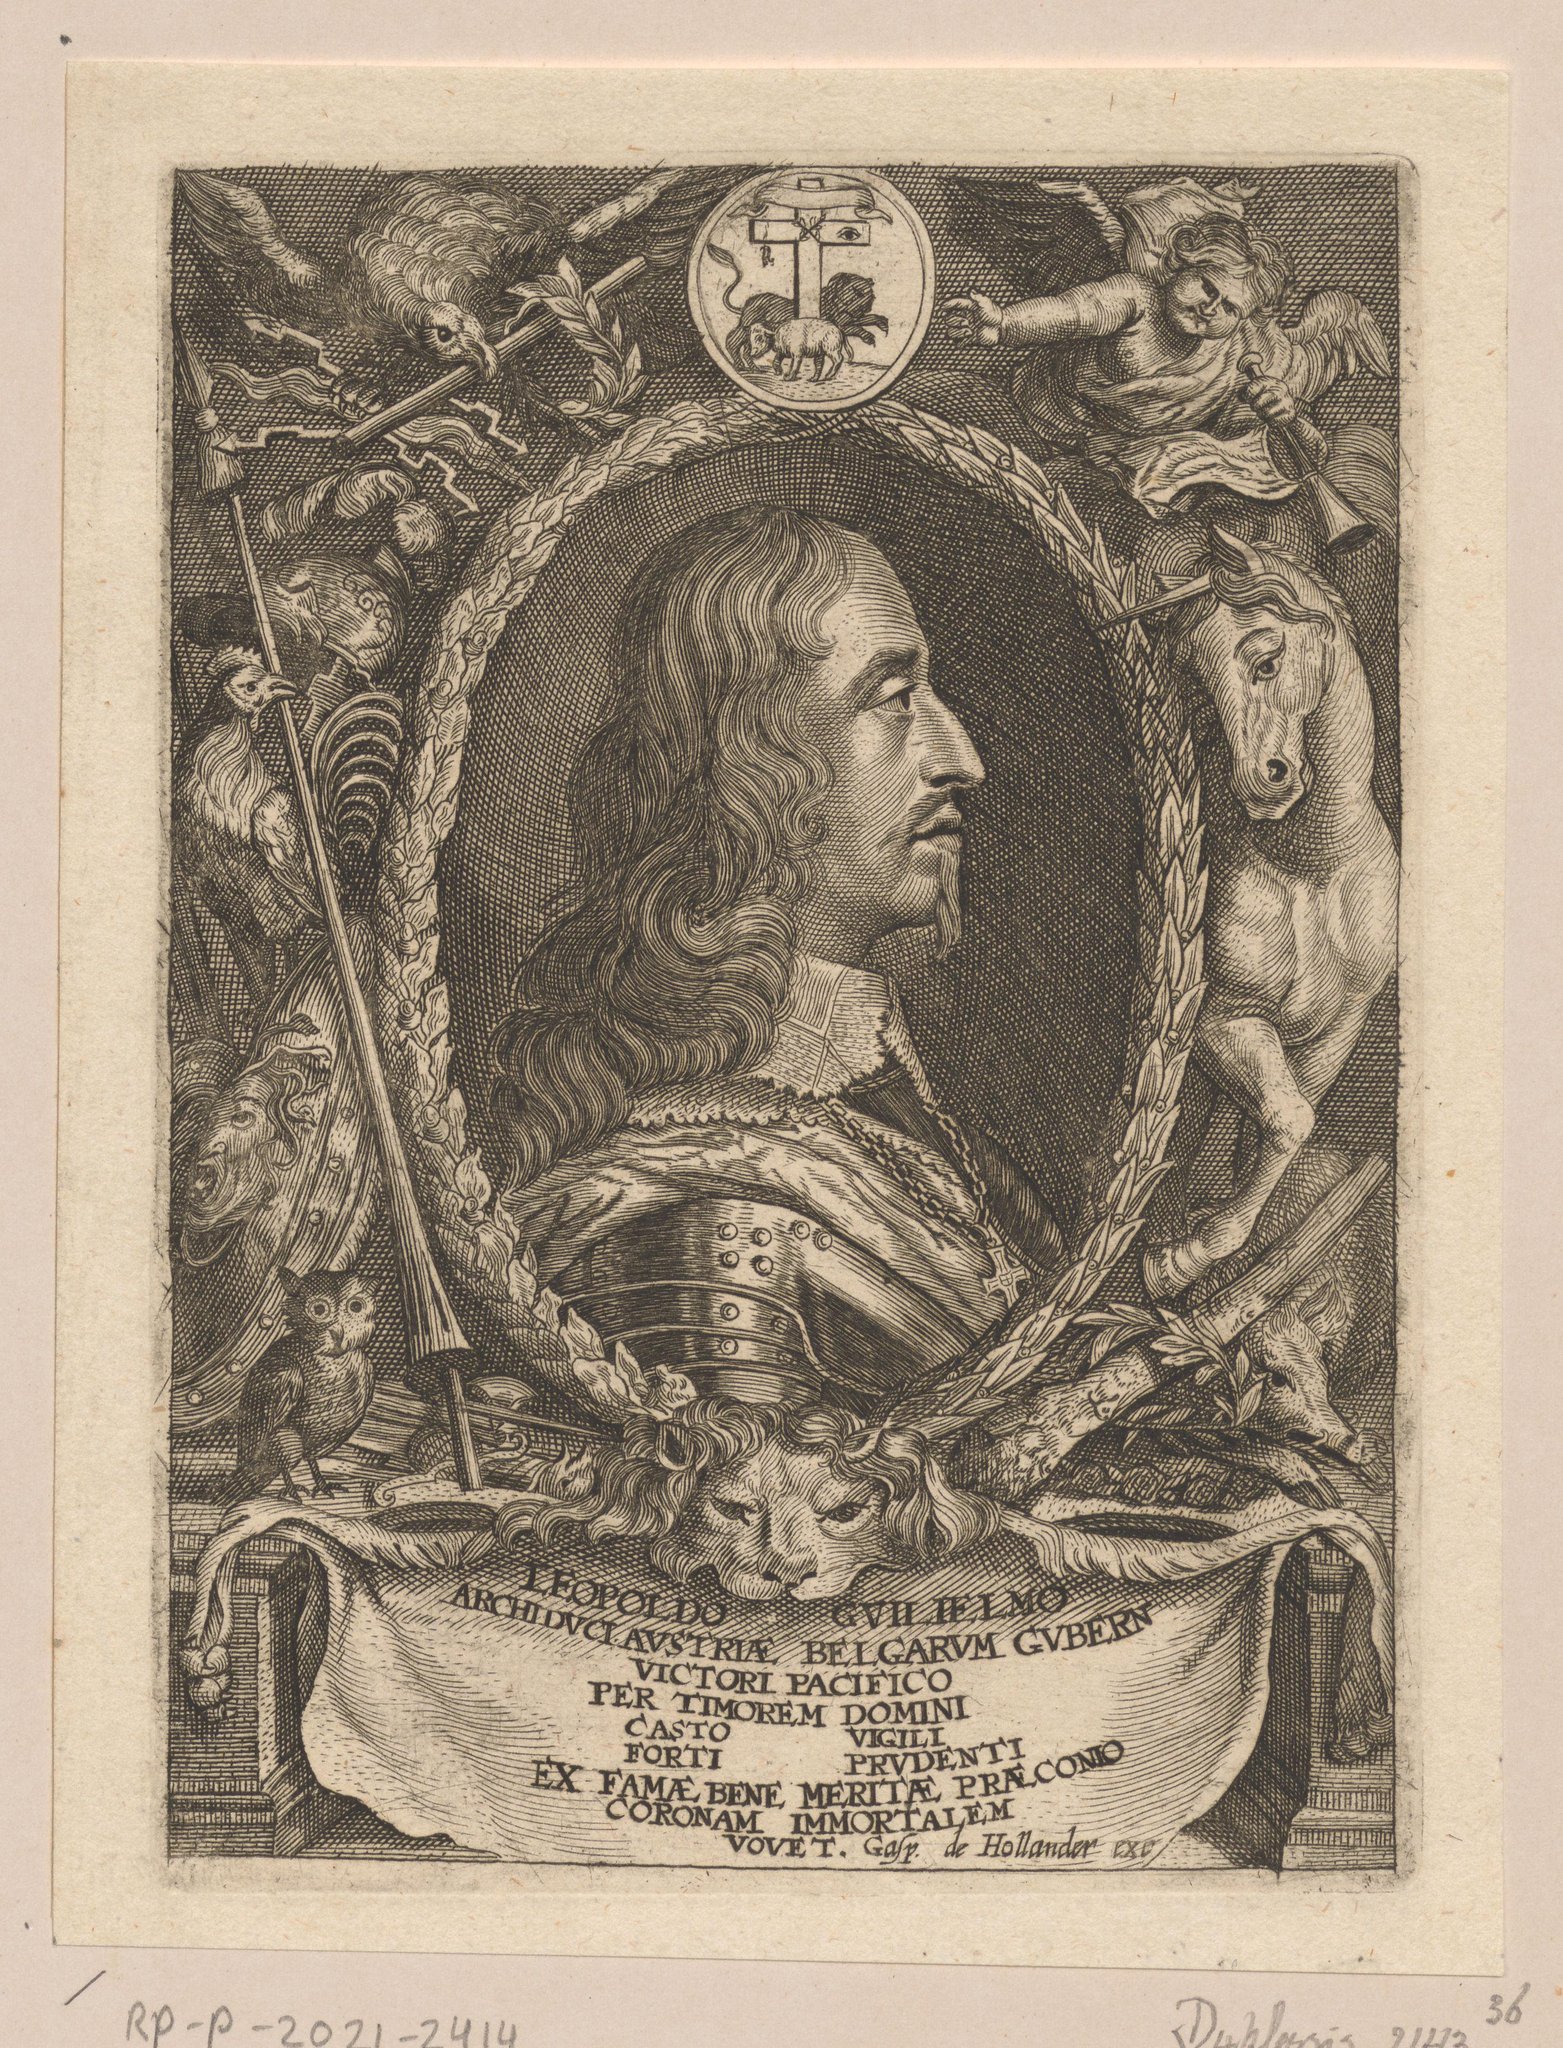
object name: print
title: Portret van Leopold Willem van Oostenrijk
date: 1647-1662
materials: paper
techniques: engraving, etching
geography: southern netherlands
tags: vienna, leopold willem van oostenrijk (landvoogd der zuidelijke nederlanden), lion's head ~ ornament, unicorn, ornament ~ medallion, armour, historical persons, armorial bearing, heraldry (...) - device, motto, attributes of minerva: owl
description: Met onderschrift in het Latijn. Omlijsting met verschillende (fantasie)dieren en links attributen van Minerva.